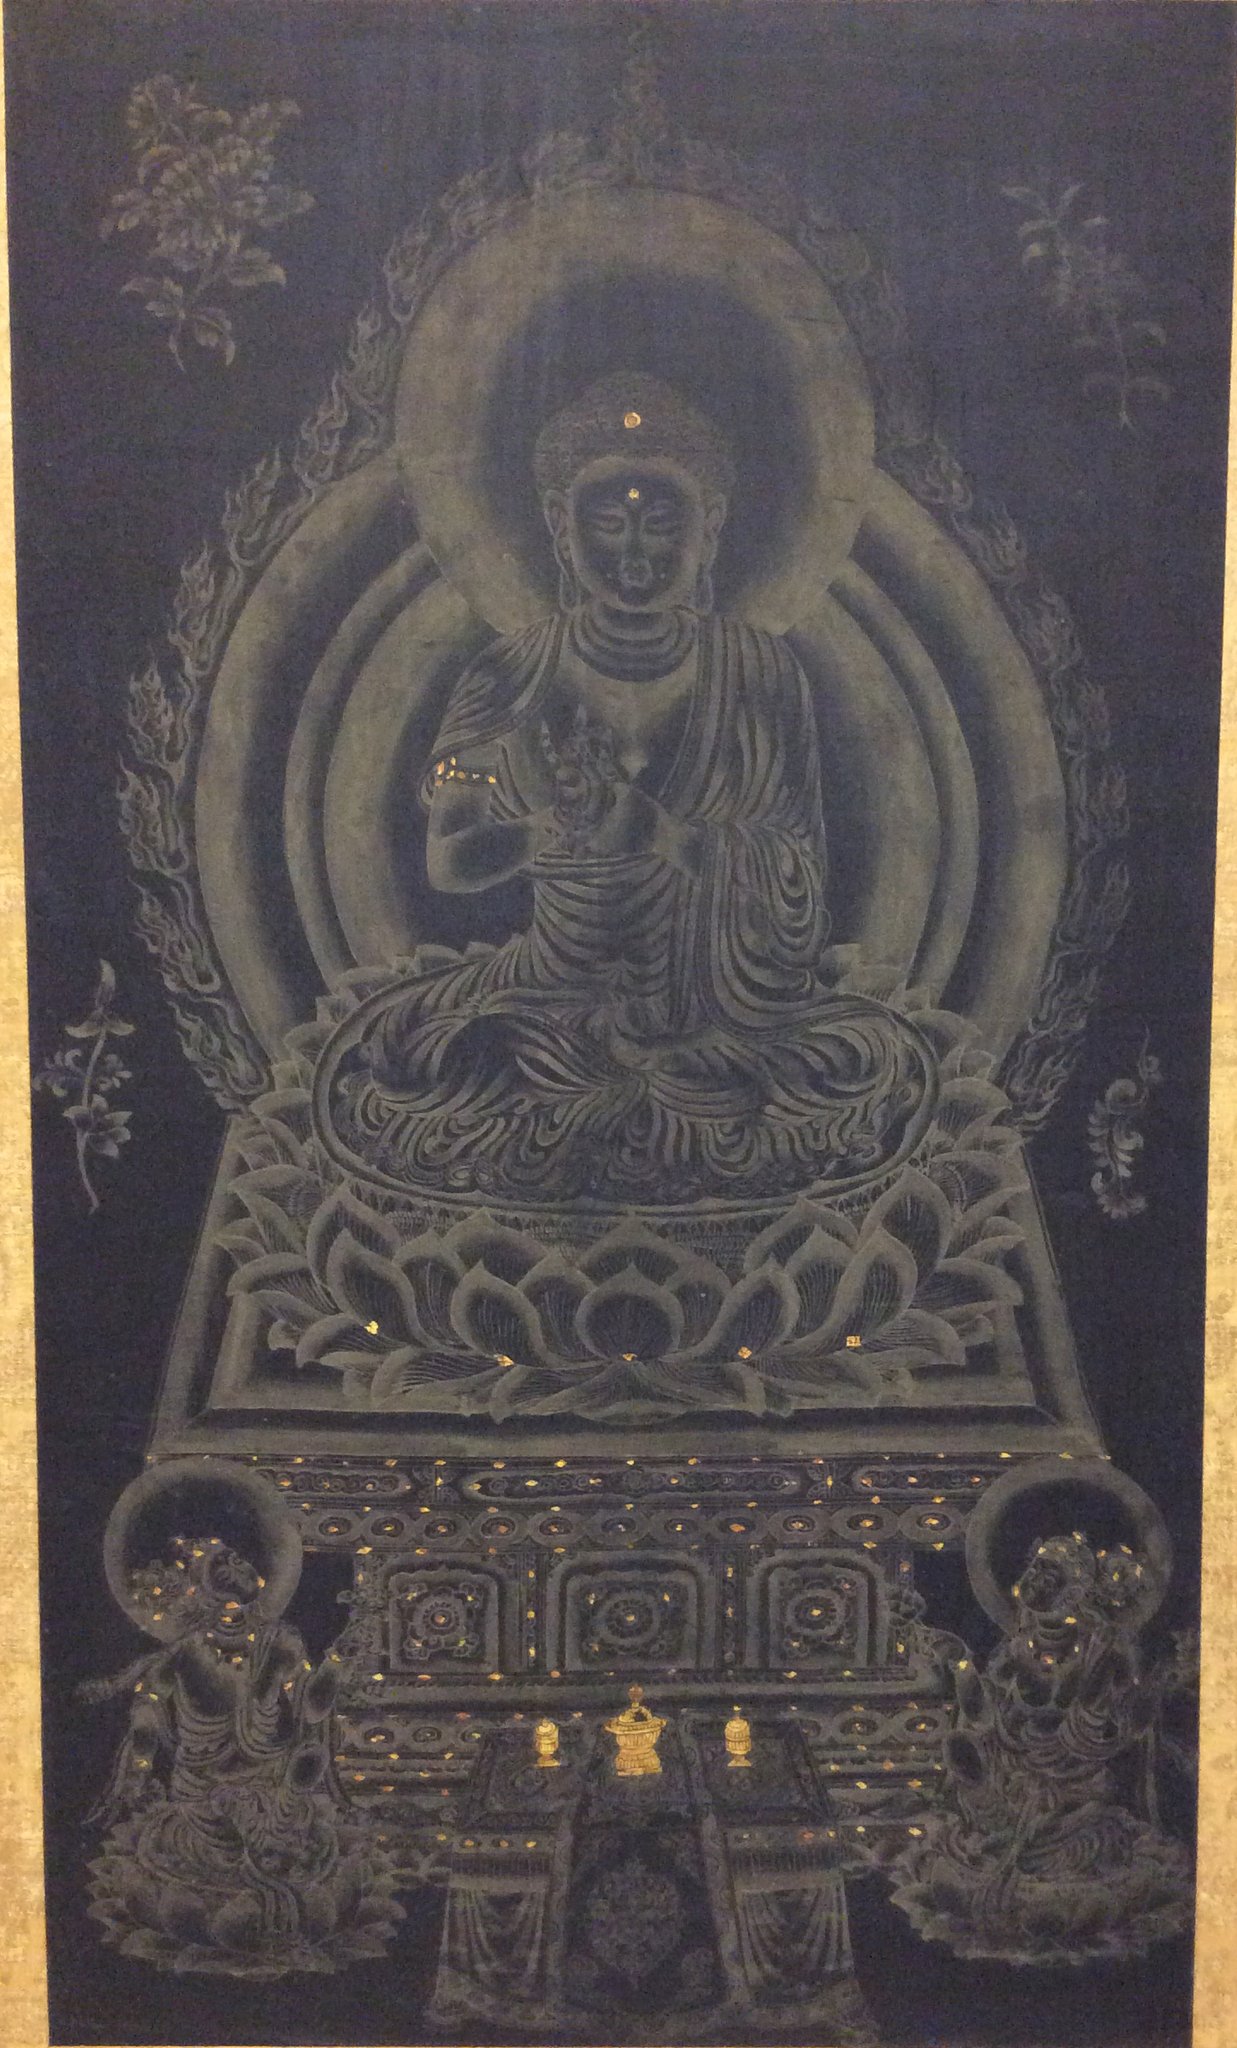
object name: hanging scroll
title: Buddha Seated on Lotus Throne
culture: chinese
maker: jiang jun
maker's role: artist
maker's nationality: chinese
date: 1644-1911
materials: ink, silk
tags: buddhism,buddha